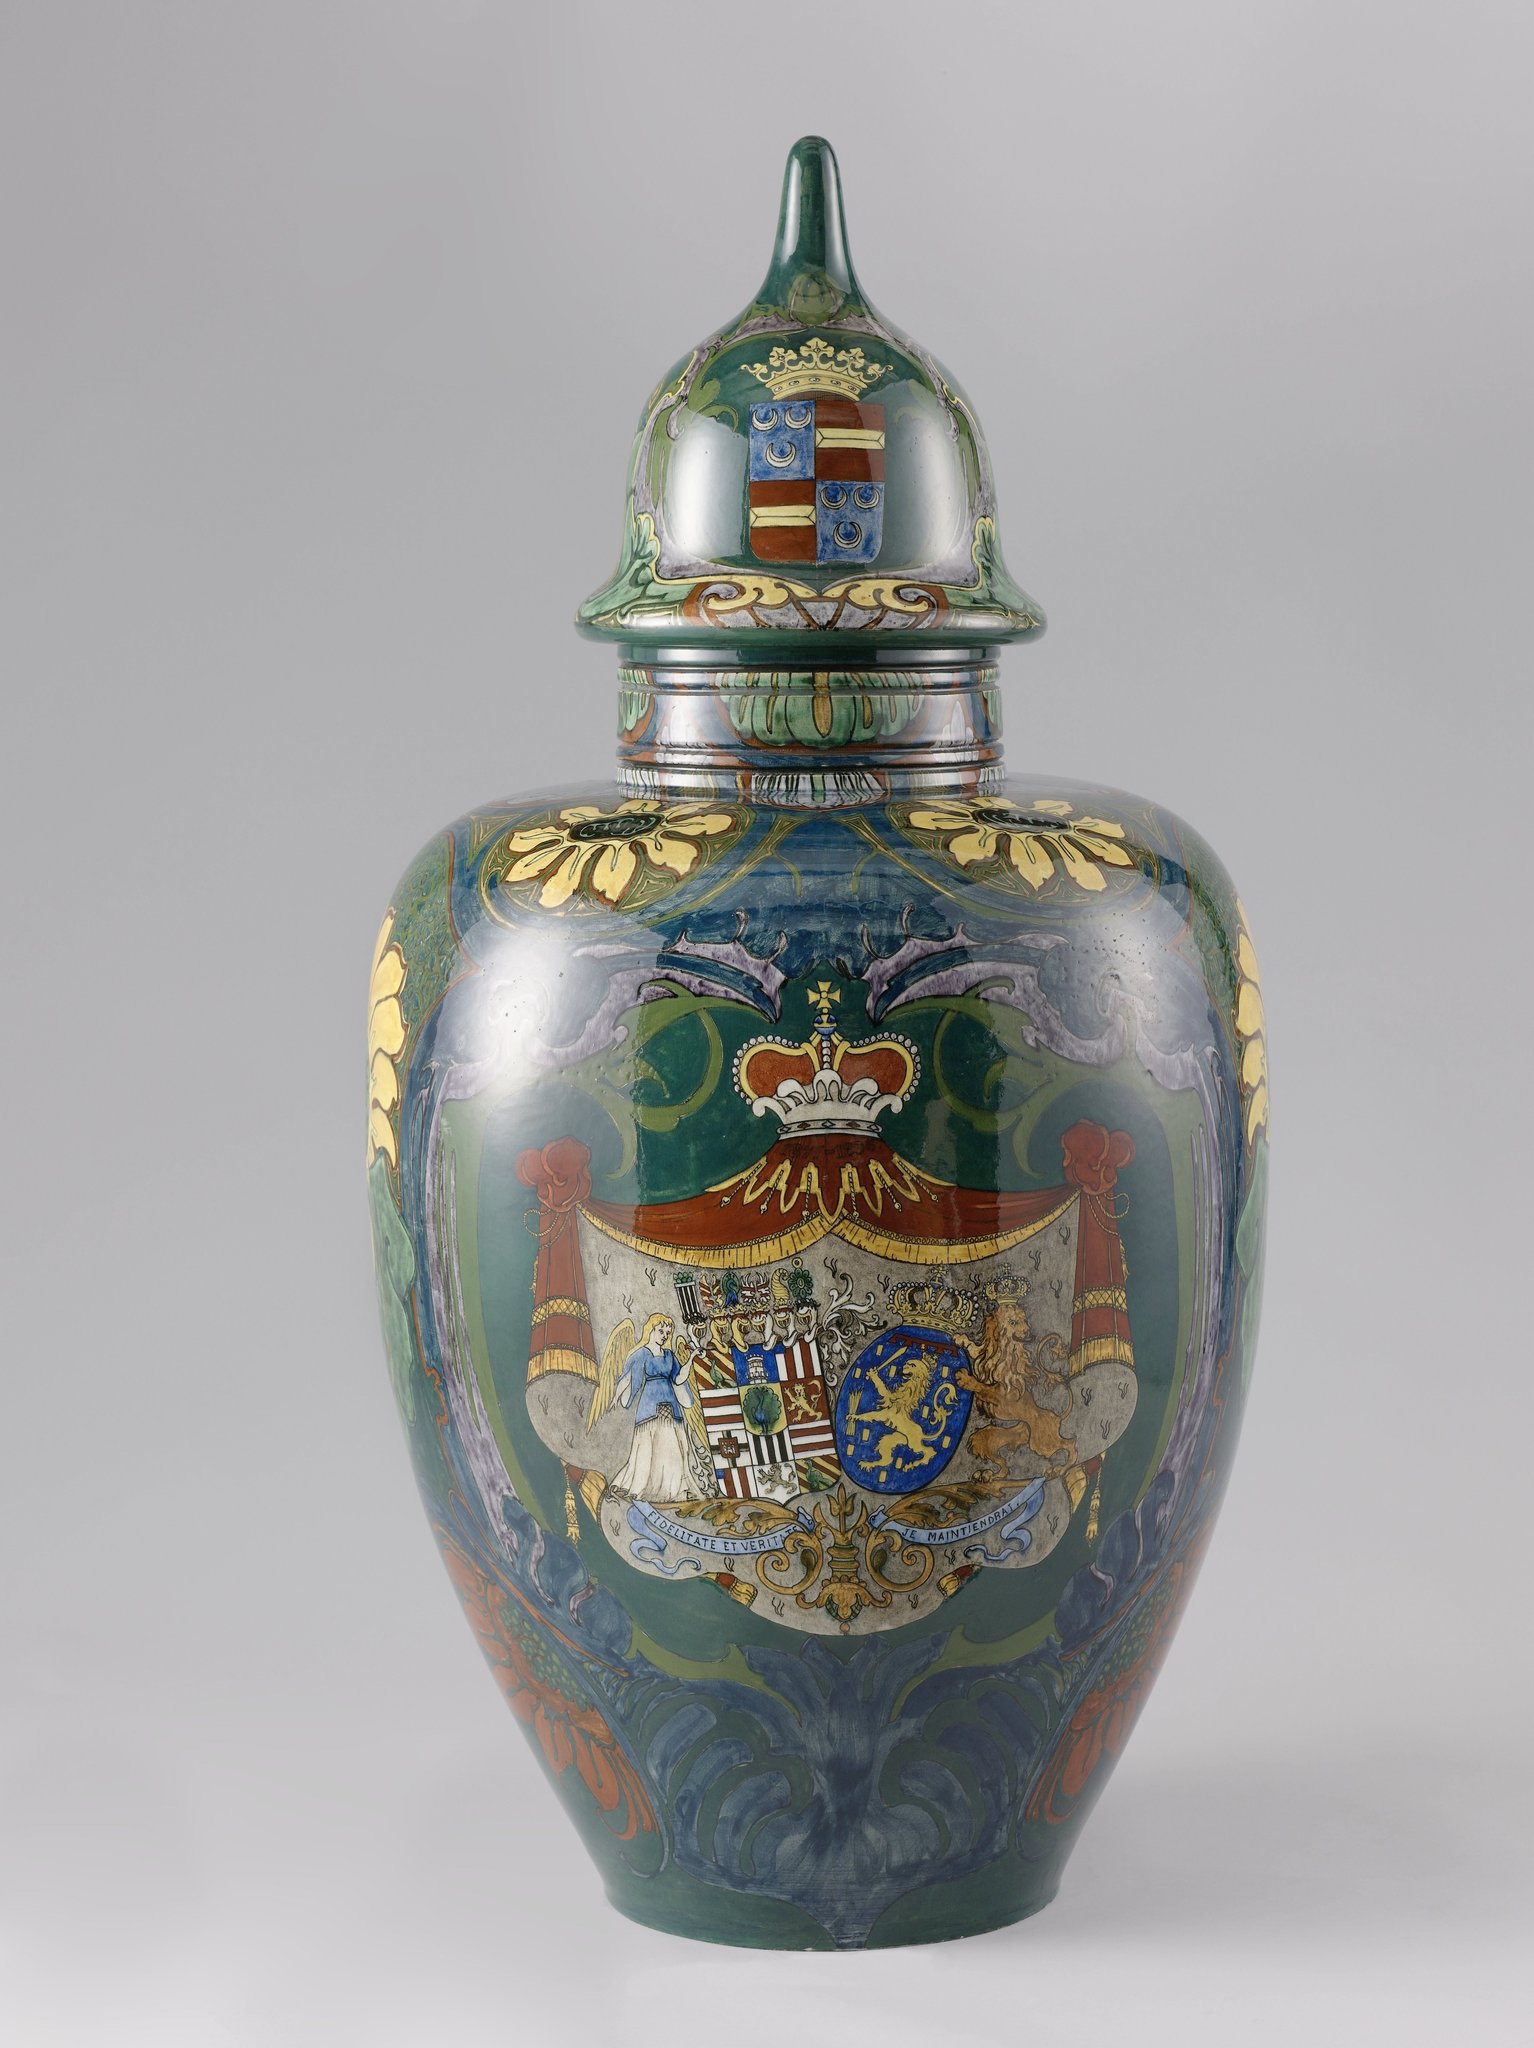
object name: vase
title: Vaas met deksel met alliantiewapen en het interieur van de Nederlands Hervormde Kerk te Wassenaar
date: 1896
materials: earthenware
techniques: painted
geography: the hague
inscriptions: mark: ‘Rozenburg //NK x ooievaar 490// Den Haag ; NK (aaneen) x 490’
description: Vaas met deksel van aardewerk, behorend bij een stel van drie, polychroom beschilderd met zonnebloemen, wapens en topografische voorstellingen. Aan één kant is het alliantiewapen afgebeeld van Willem Adolf Maximiliaan Carel, vorst van Wied en zijn vrouw prinses Marie der Nederlanden, waarboven 1871-1896, aan de andere kant is het interieur van de Nederlands Hervormde Kerk van Wassenaar afgebeeld. Op het puntig toelopende deksel is het wapen van de gemeente Wassenaar afgebeeld. Tussen en boven de voorstellingen zijn zonnebloemen geschilderd.